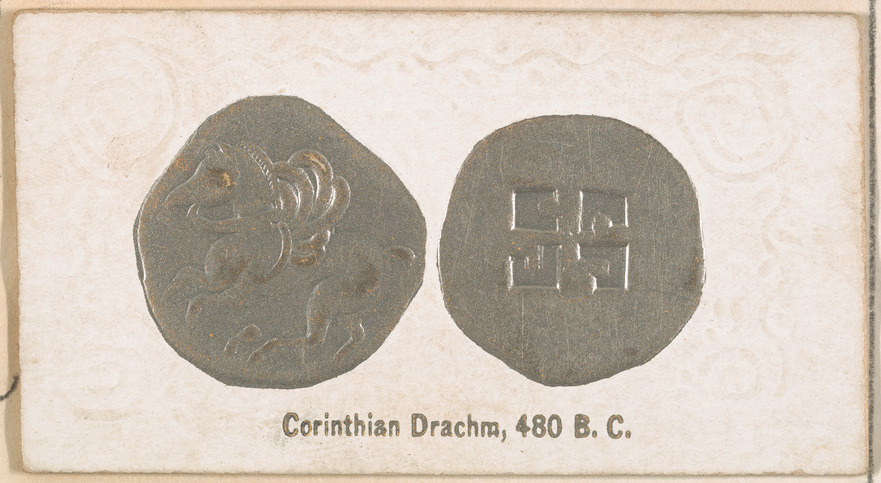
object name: print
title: Corinthian Drachm, 480 B.C., from the Ancient Coins series (N180) issued by Wm. S. Kimball & Co.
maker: william s. kimball & company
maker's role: publisher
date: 1888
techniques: color lithograph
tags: coins